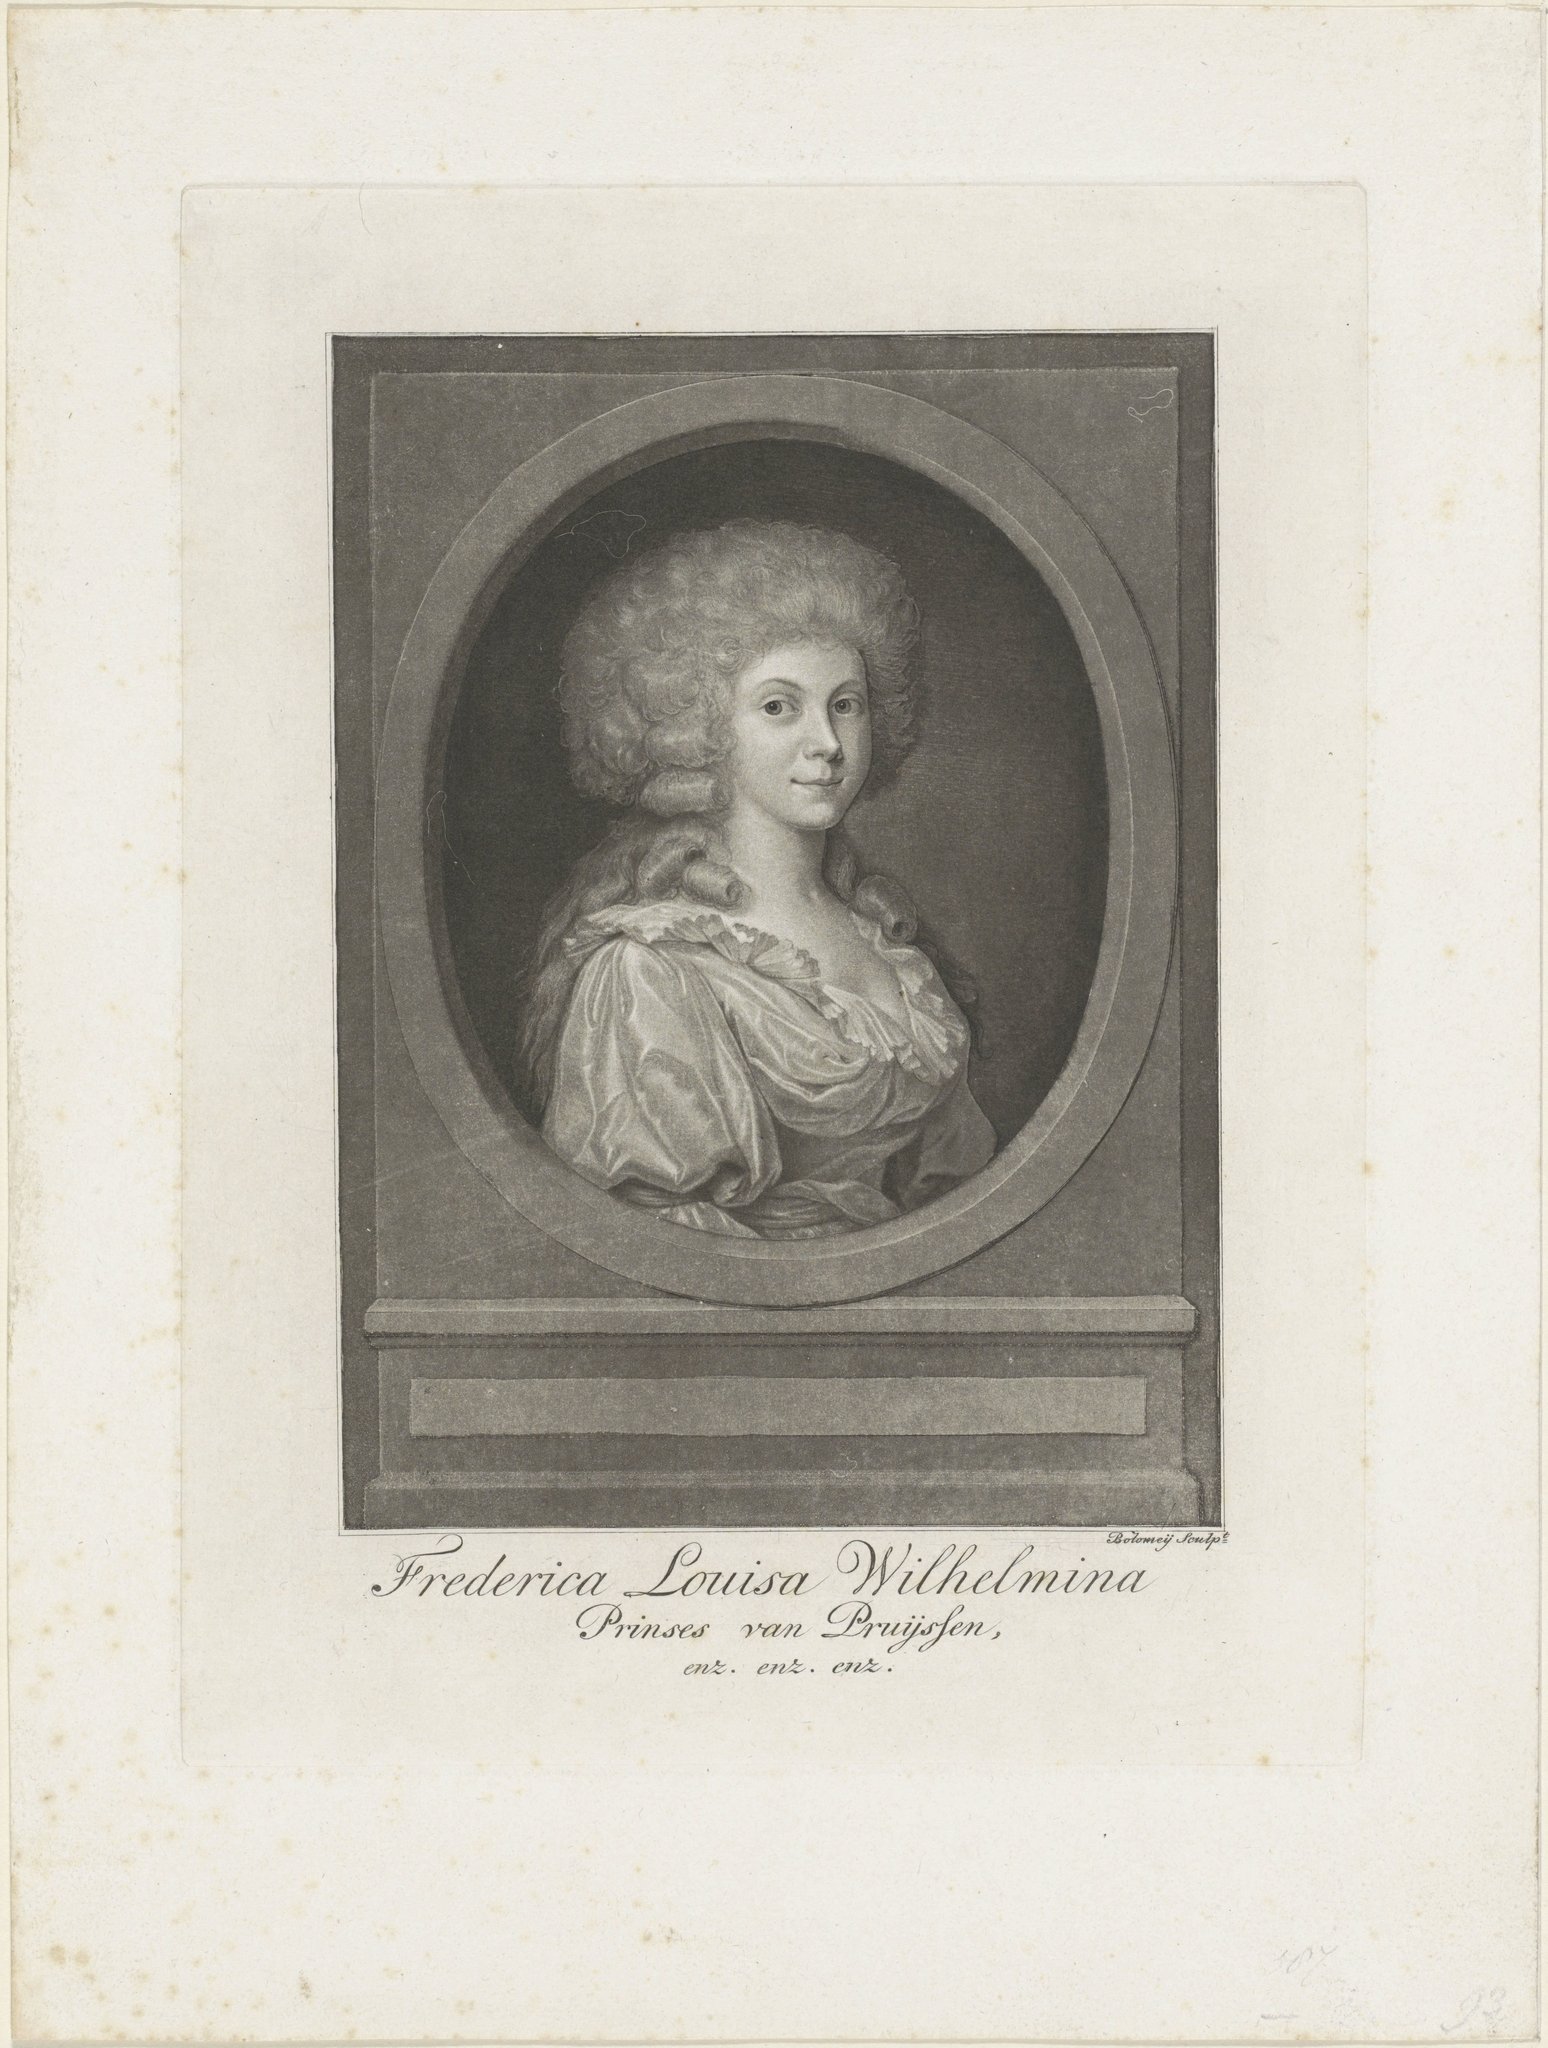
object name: print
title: Portret van Wilhelmina van Pruisen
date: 1790-1819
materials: paper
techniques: aquatint, etching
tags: berlin, the hague, wilhelmina frederica louisa (koningin der nederlanden)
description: Portret van Wilhelmina in een ovaal. In de ondermarge haar naam en titels.